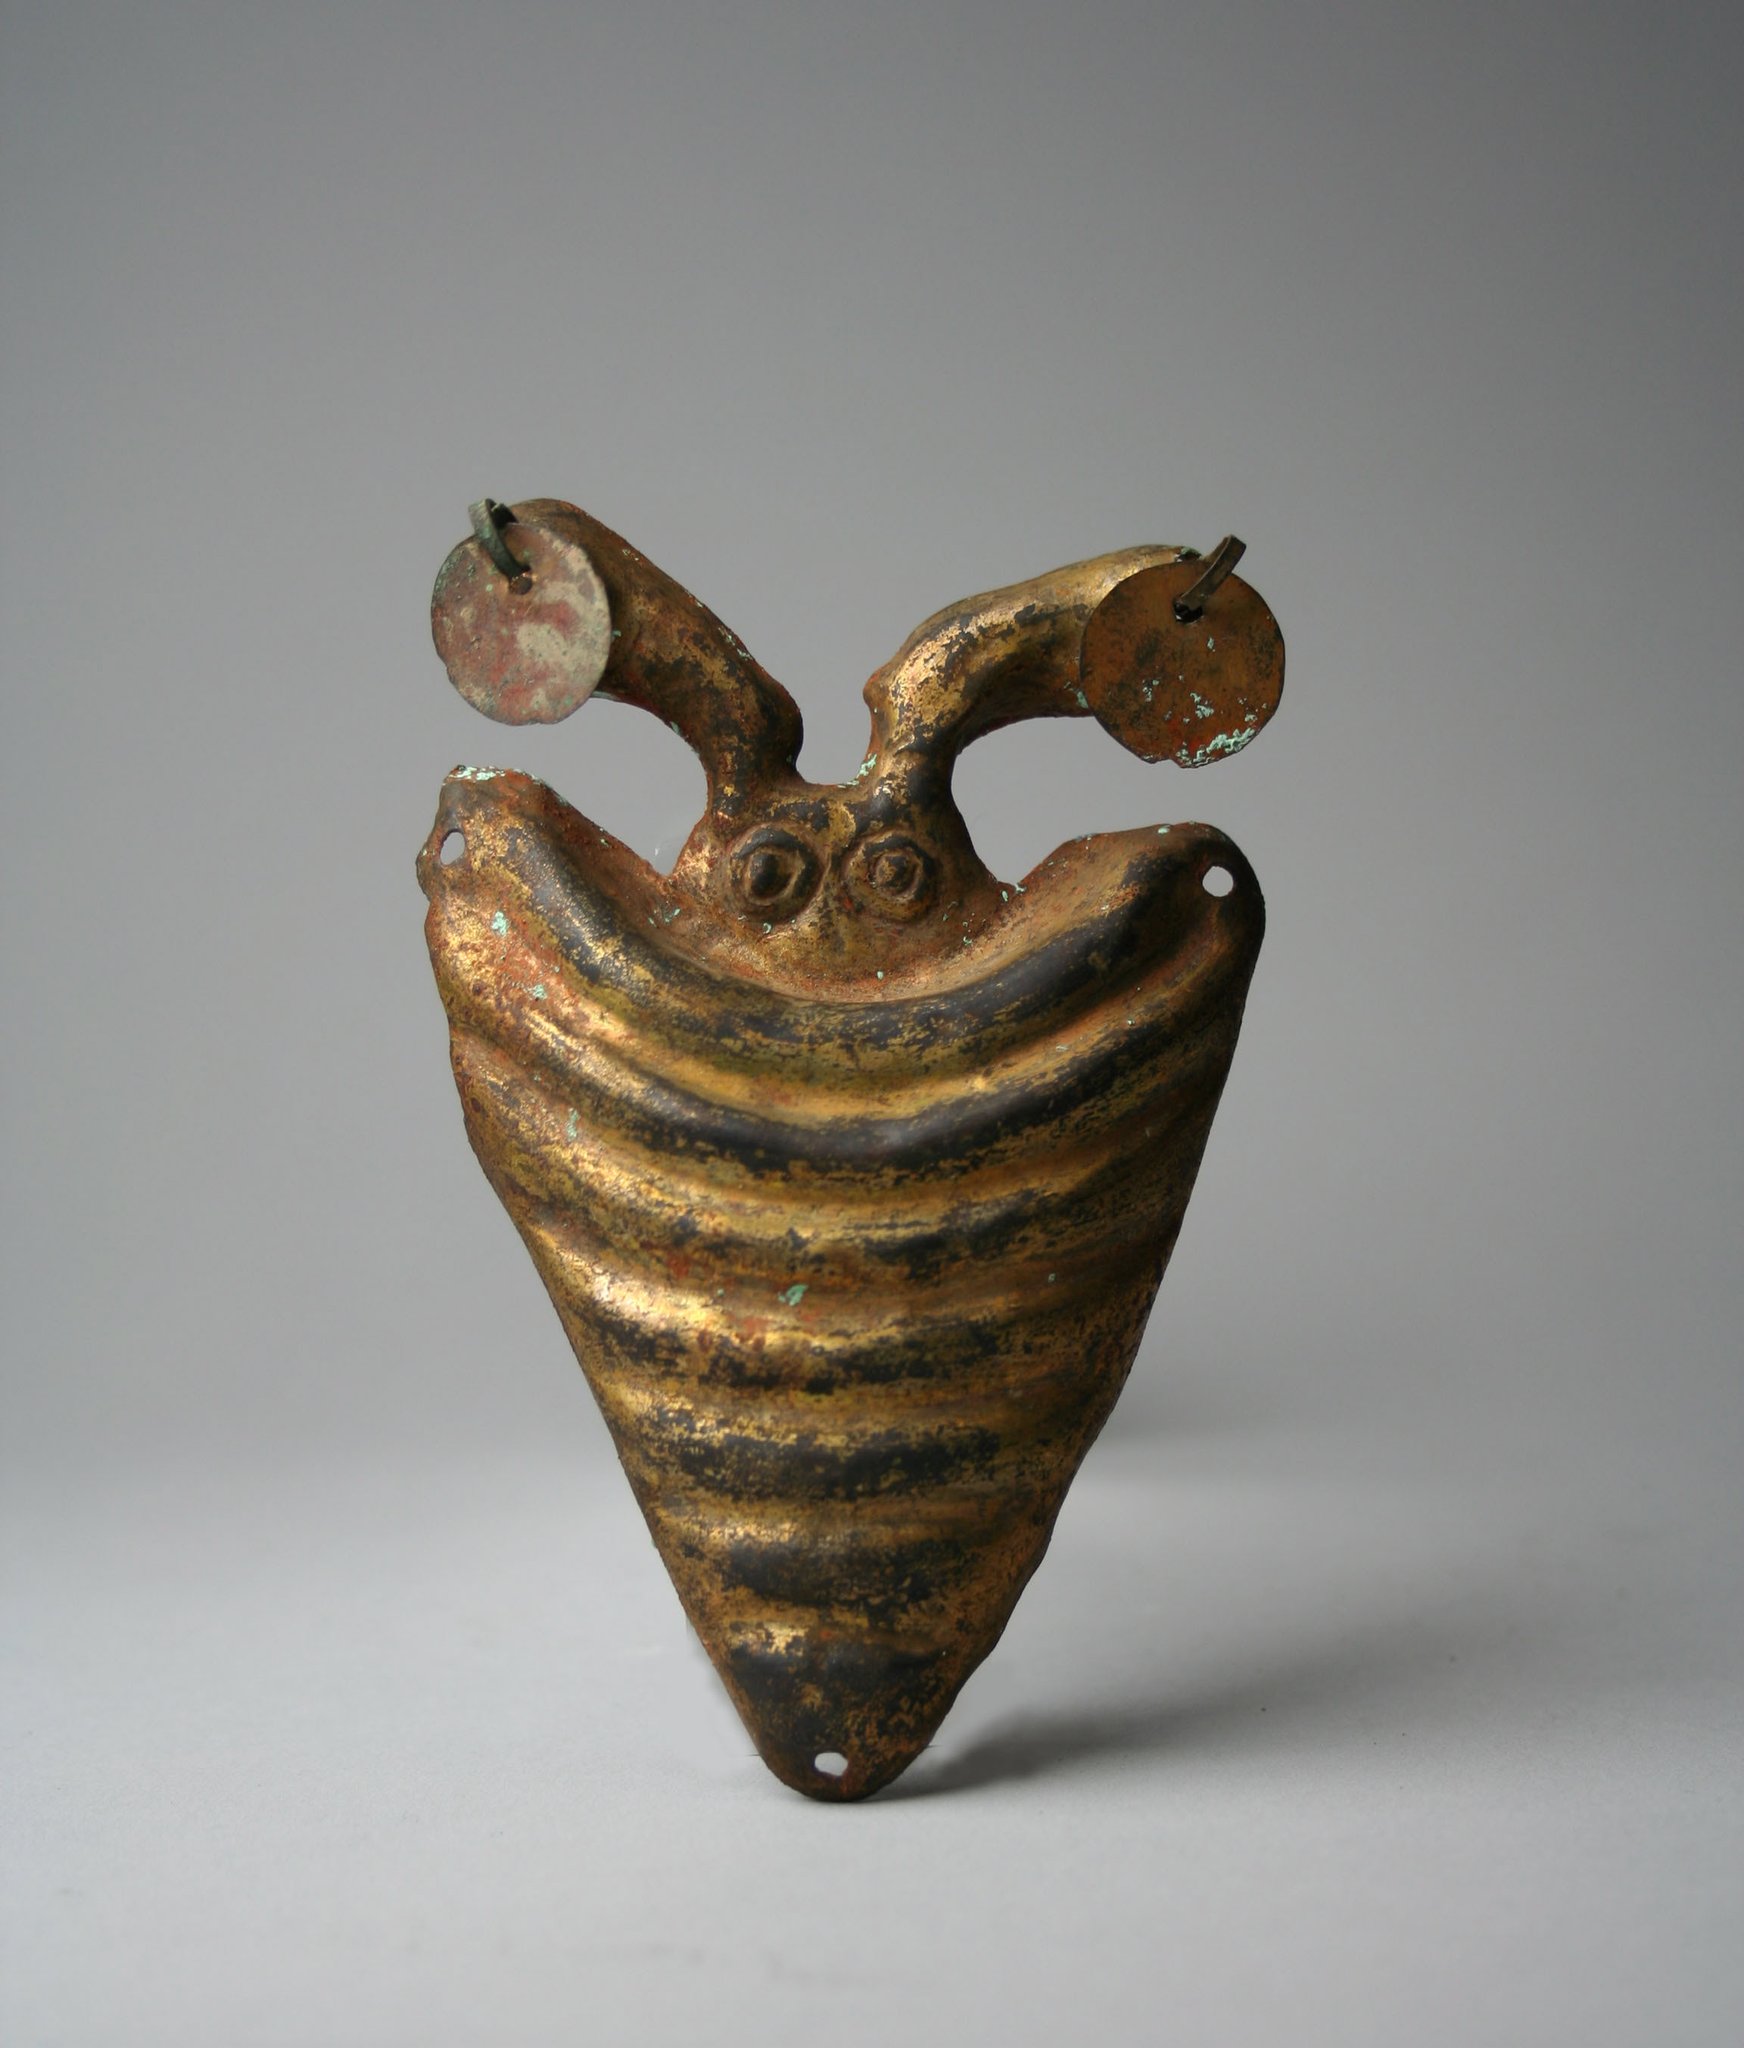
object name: ornament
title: Animal Ornament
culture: moche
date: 501-700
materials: gilt copper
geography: peru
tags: animals